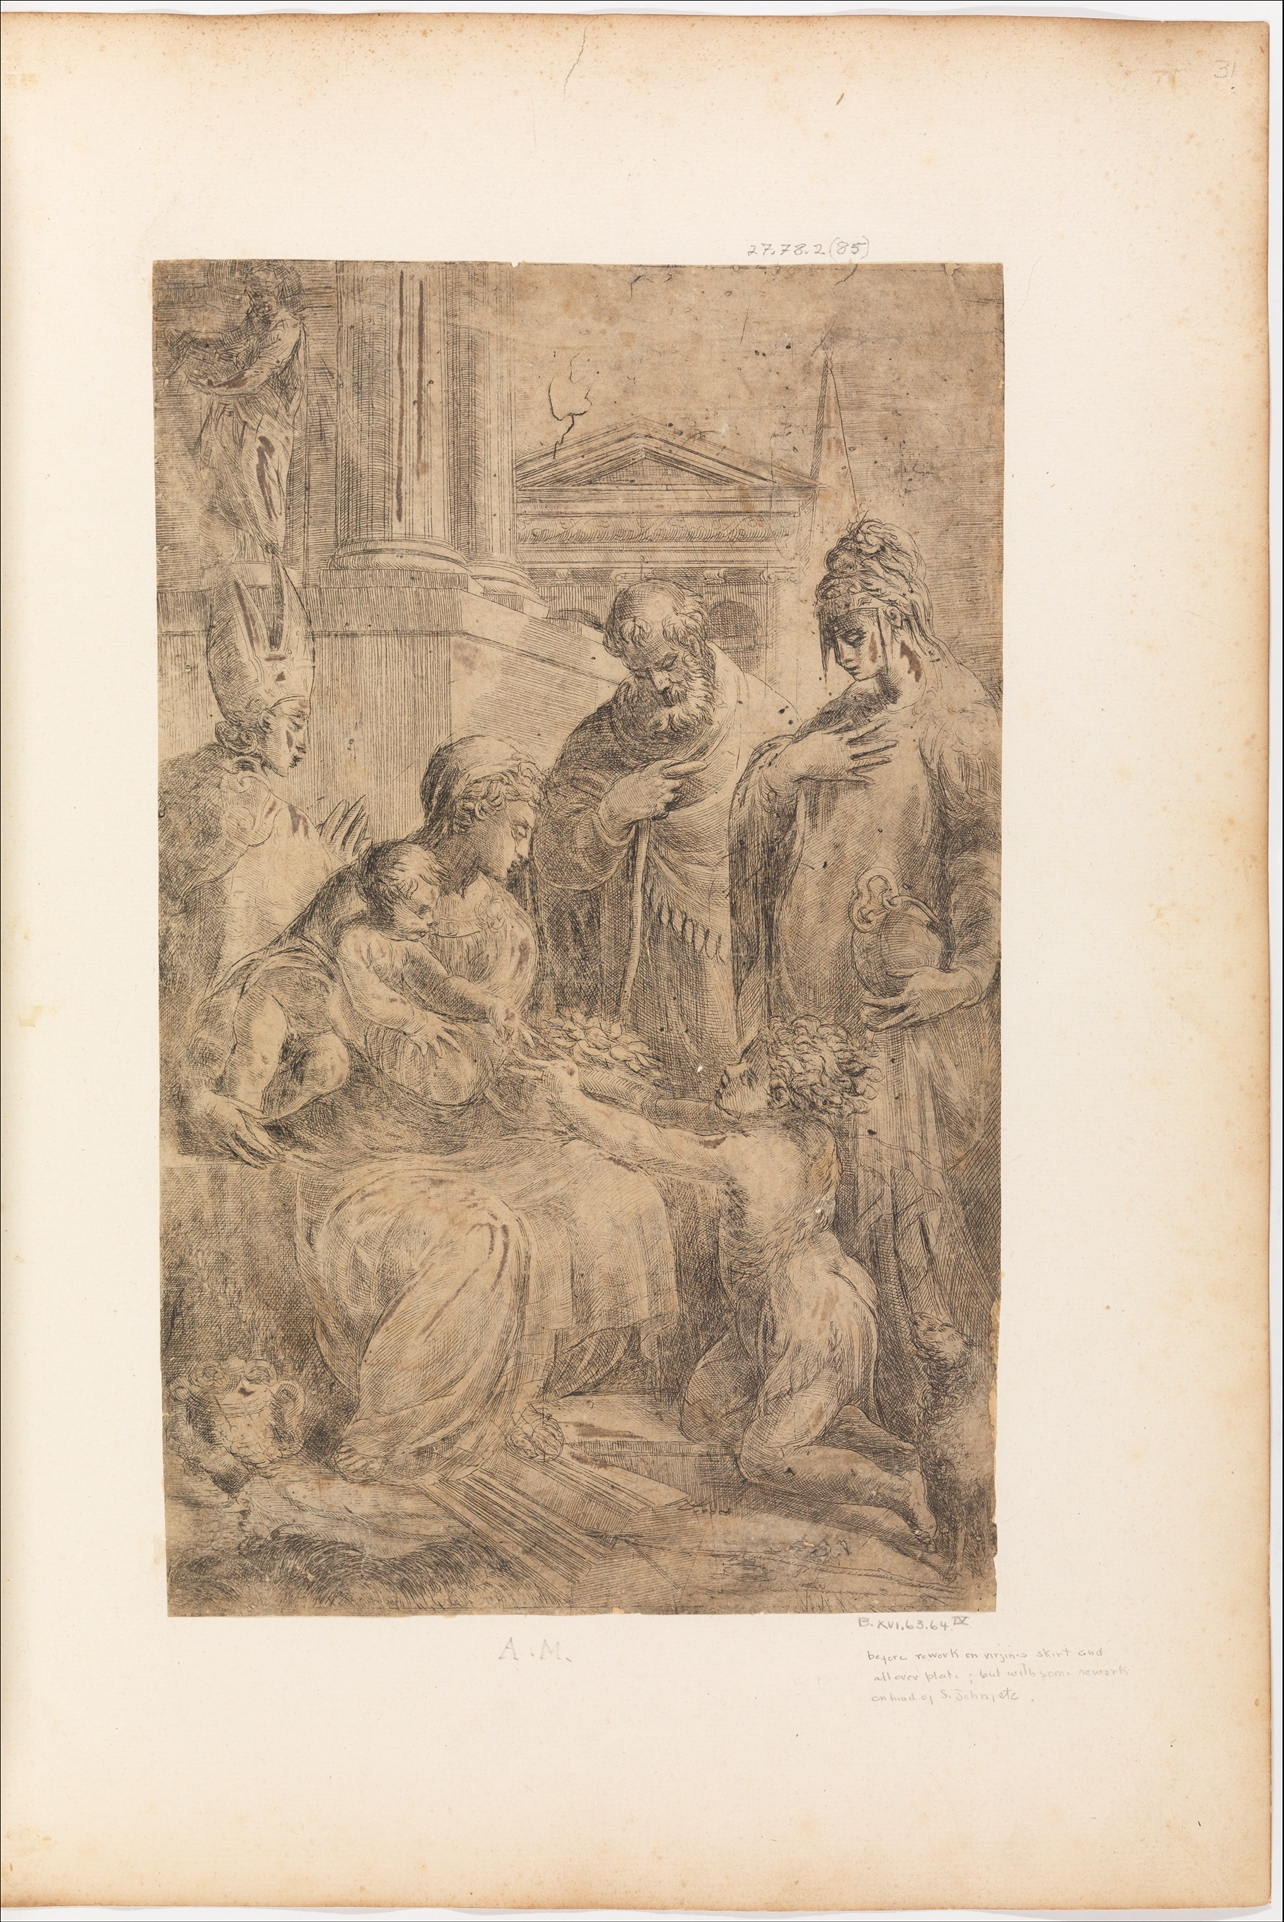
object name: print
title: Holy Family with Saints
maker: andrea schiavone (andrea meldola)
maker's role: artist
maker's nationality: italian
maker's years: 1510-1563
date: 1550-1554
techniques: etching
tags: children,men,women,holy family,saints